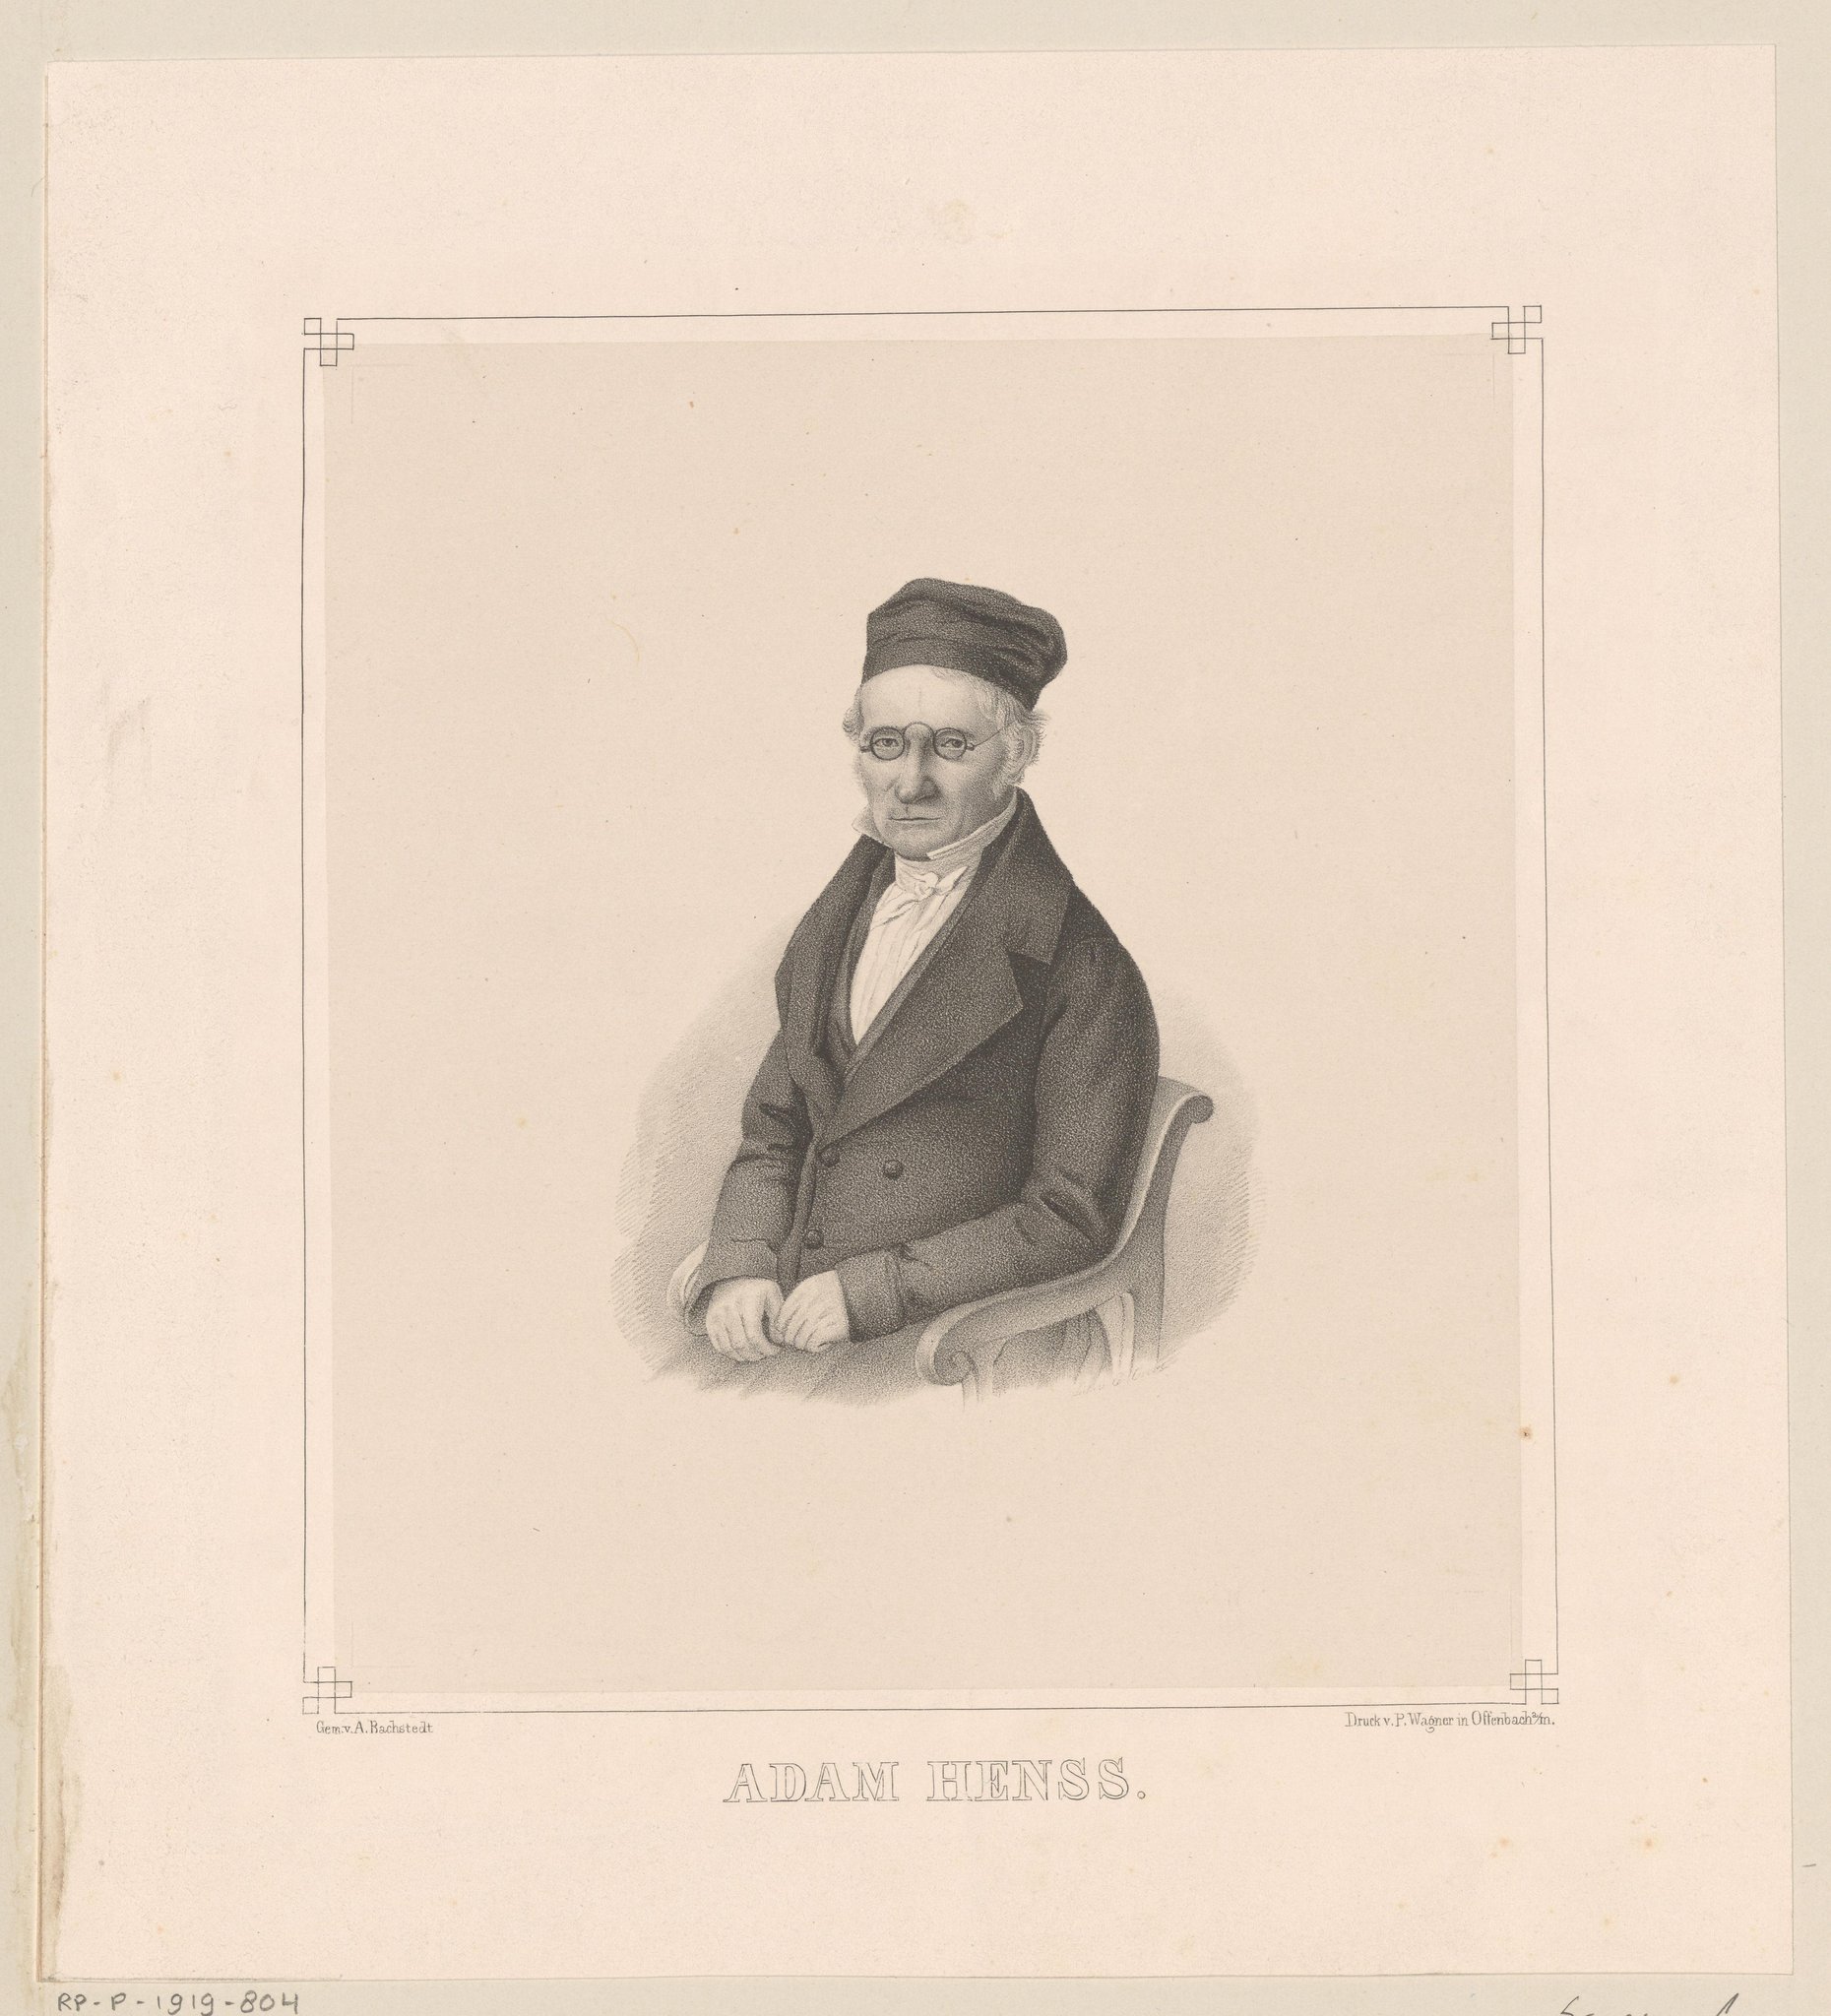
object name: print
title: Portret van Adam Henss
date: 1830-1874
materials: paper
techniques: lithograph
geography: offenbach am main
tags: eyeglasses, spectacles, historical persons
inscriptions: collector's mark: Lugt 2228